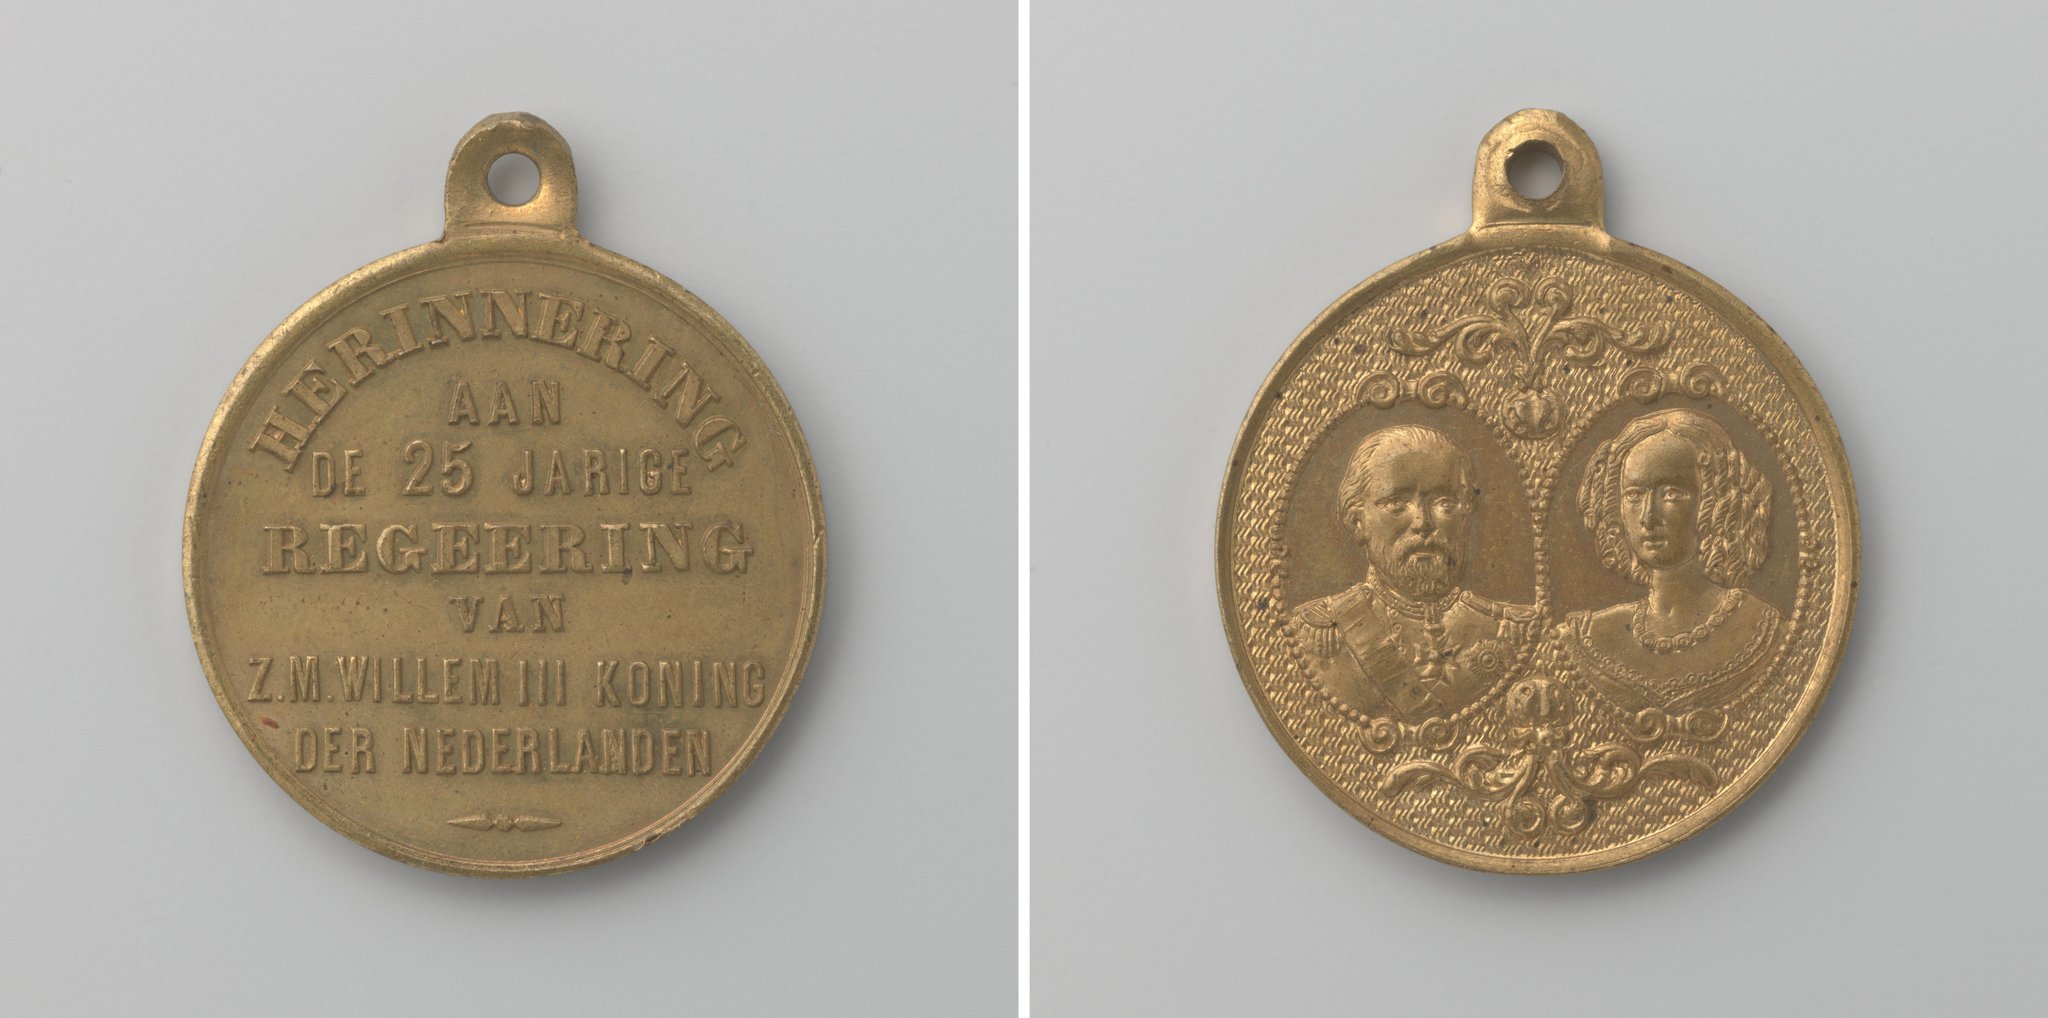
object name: insignia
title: Vijfentwintigjarig regeringsjubileum van Koning Willem III en Koningin Sophia 1874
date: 1874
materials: brass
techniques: striking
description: Messing penning met draagoog, op de voorzijde twee ovale medaillons met de aanziende portretten van Willem III en Sophia, waarbuiten een gematteerd veld met bladornamenten, op de keerzijde zeven regels tekst.